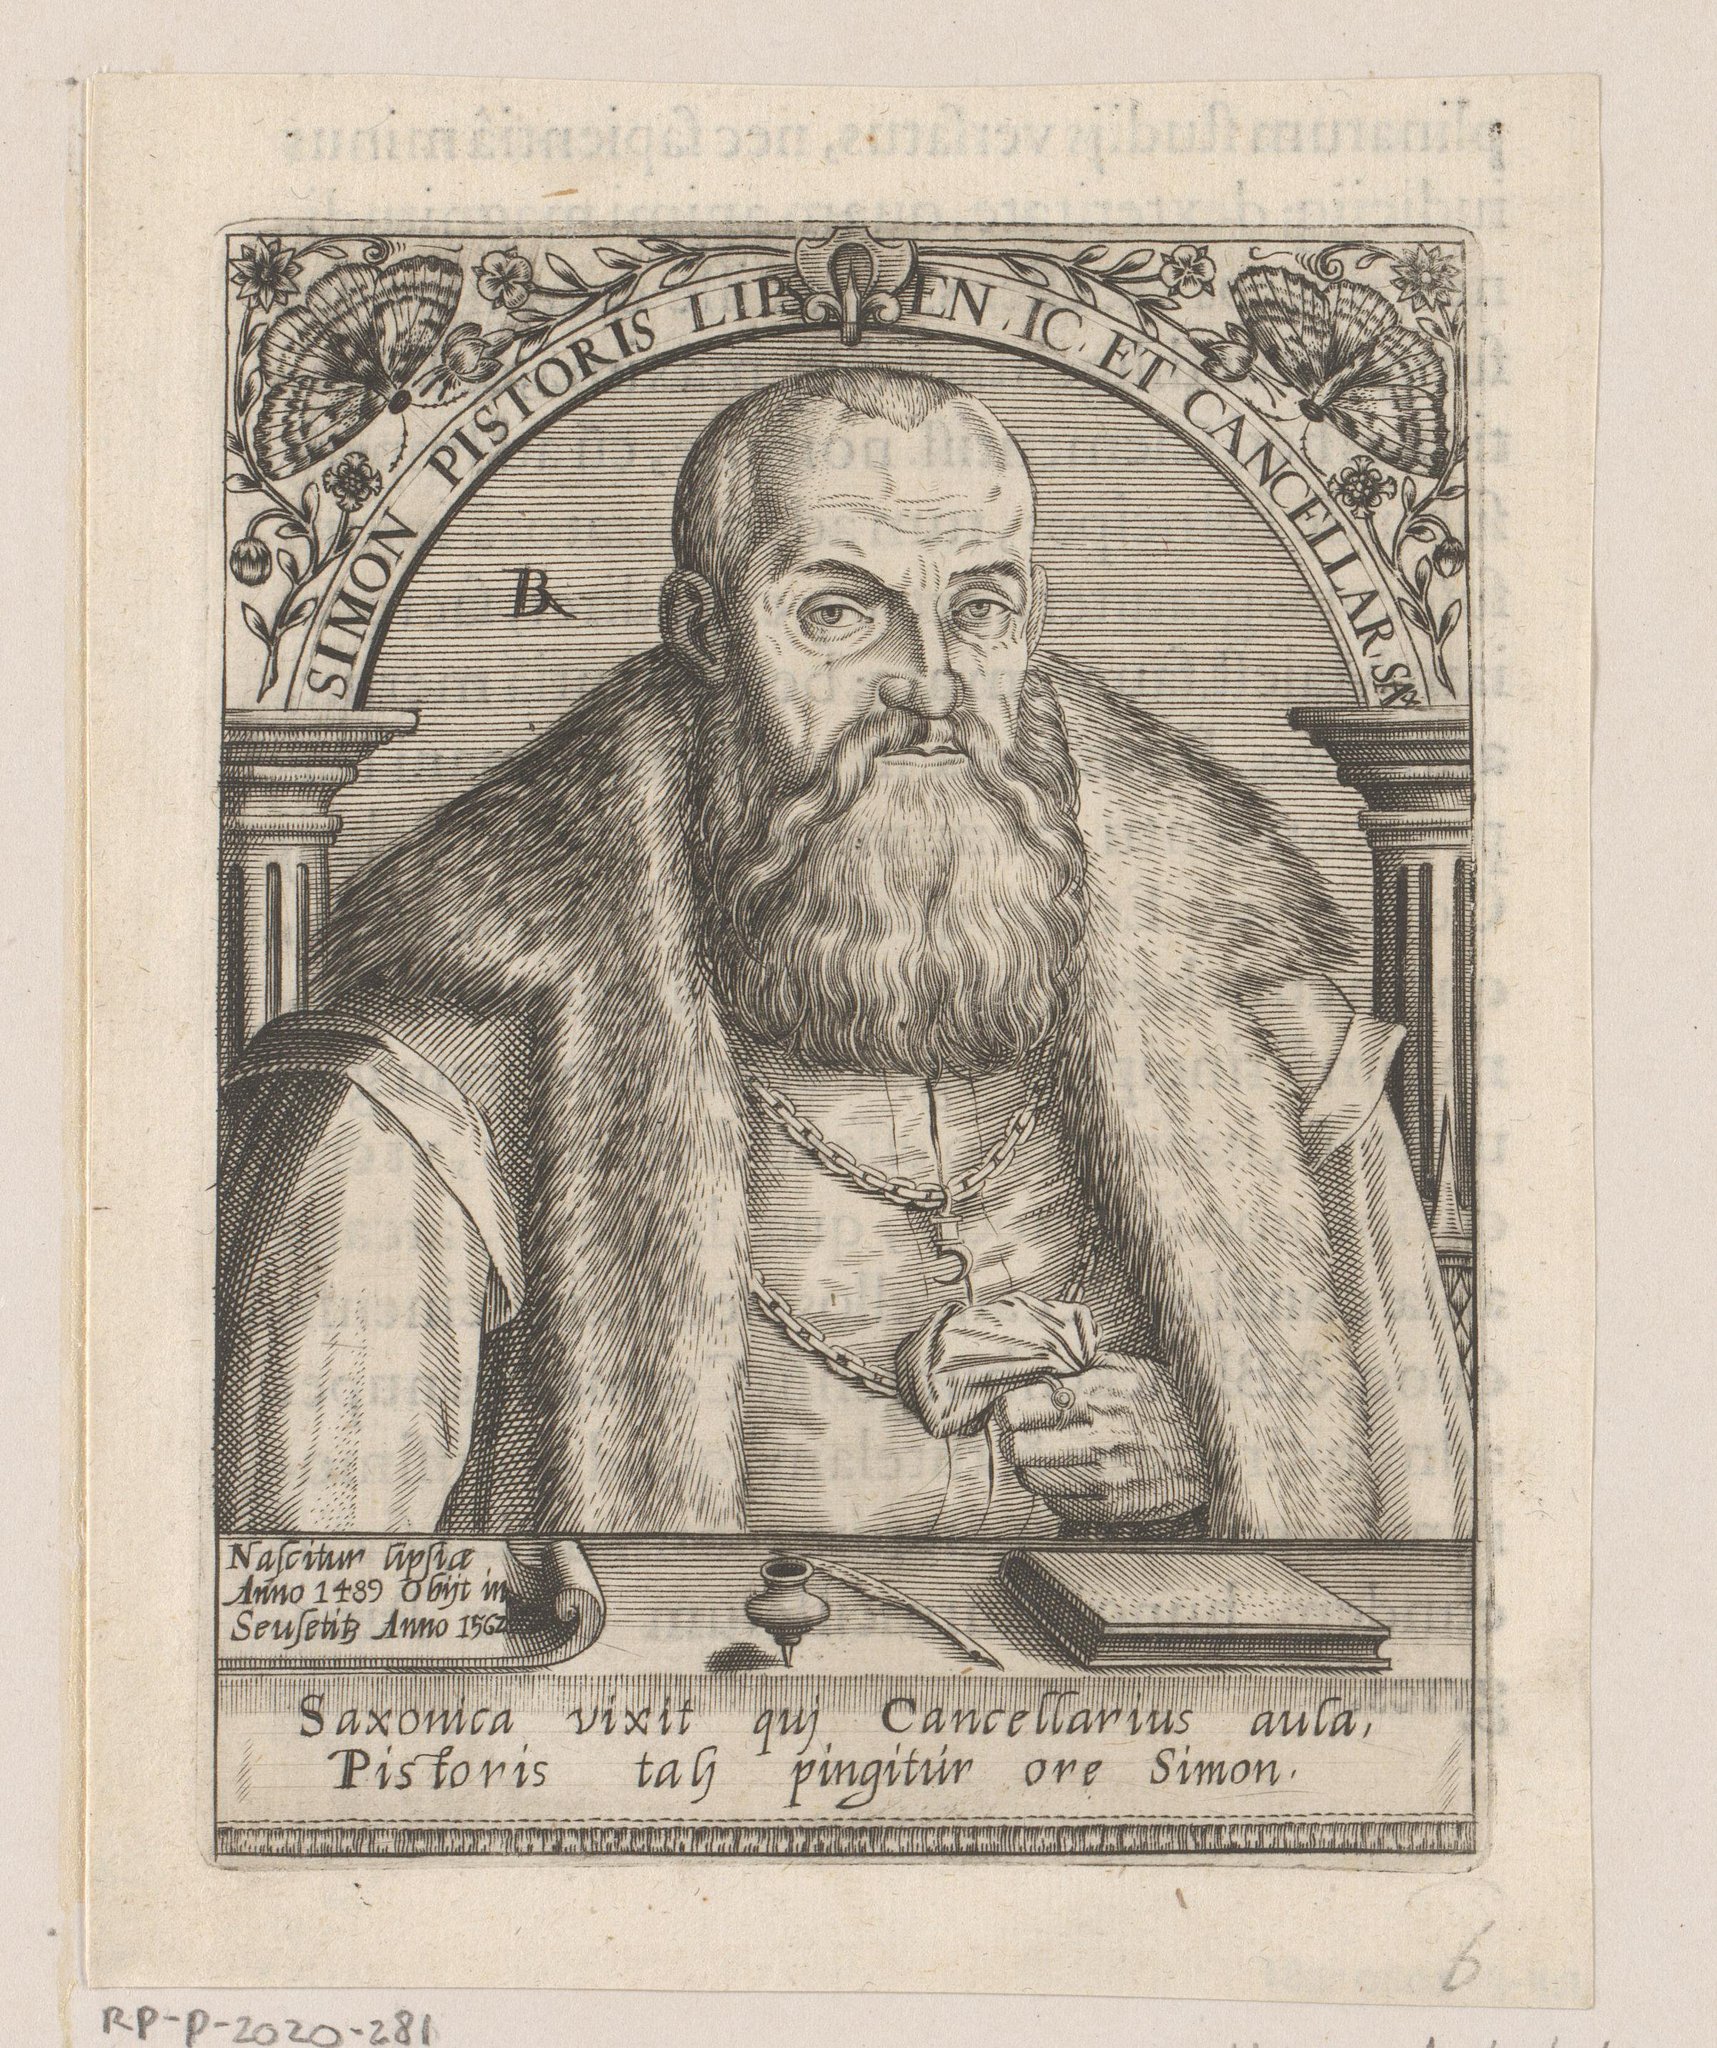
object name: book illustration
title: Portret van Simon Pistoris II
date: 1599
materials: paper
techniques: engraving, letterpress printing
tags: historical persons, law and jurisprudence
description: Prent uit: Boissard, Jean Jacques. Icones quinquaginta virorum illustrium doctrina & eruditione praestantium ad vivum effictae. 4 dln. Frankfurt am Main: s.n., 1597-1599, dl. 4, p. 160. Mogelijk ook gebruikt in latere edities. Latere staat van prent verschenen in: Boissard, Jean Jacques. Bibliotheca chalcographica. 8 dln. Frankfurt am Main: Johannes Ammon, 1650-1652. Ook gebruikt in latere edities.